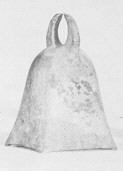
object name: bell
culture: italian, roman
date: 1-100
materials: bronze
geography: italy